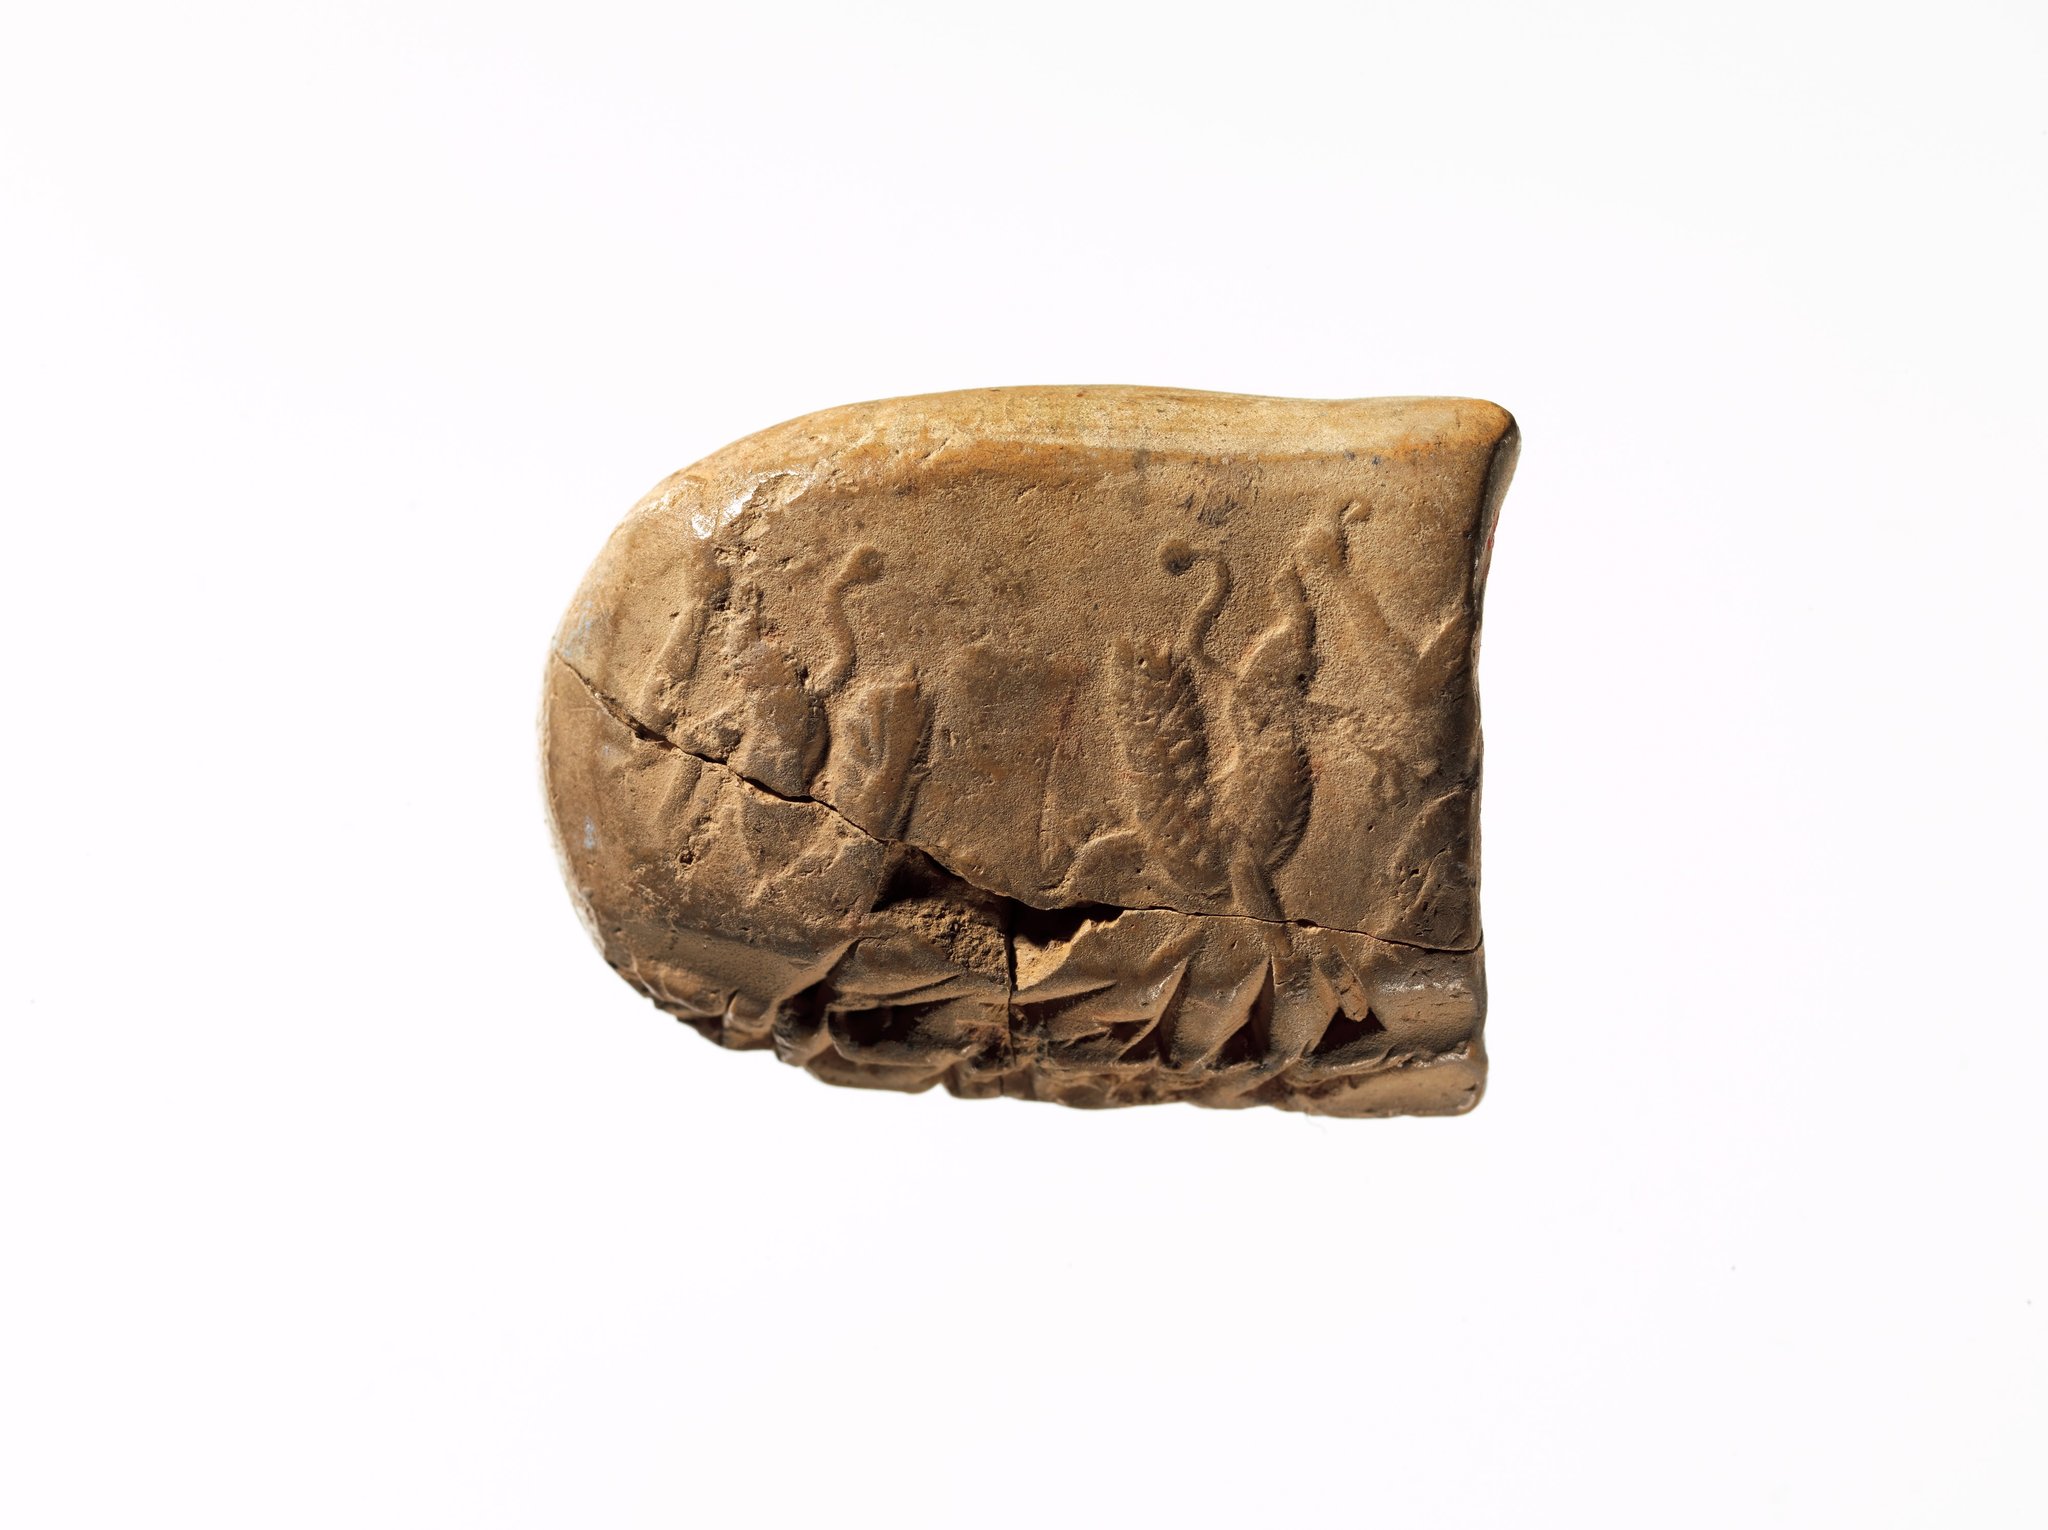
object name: cuneiform tablet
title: Cuneiform tablet impressed with seals: administrative document inscribed in Achaemenid Elamite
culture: achaemenid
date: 500 BCE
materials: clay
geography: iran